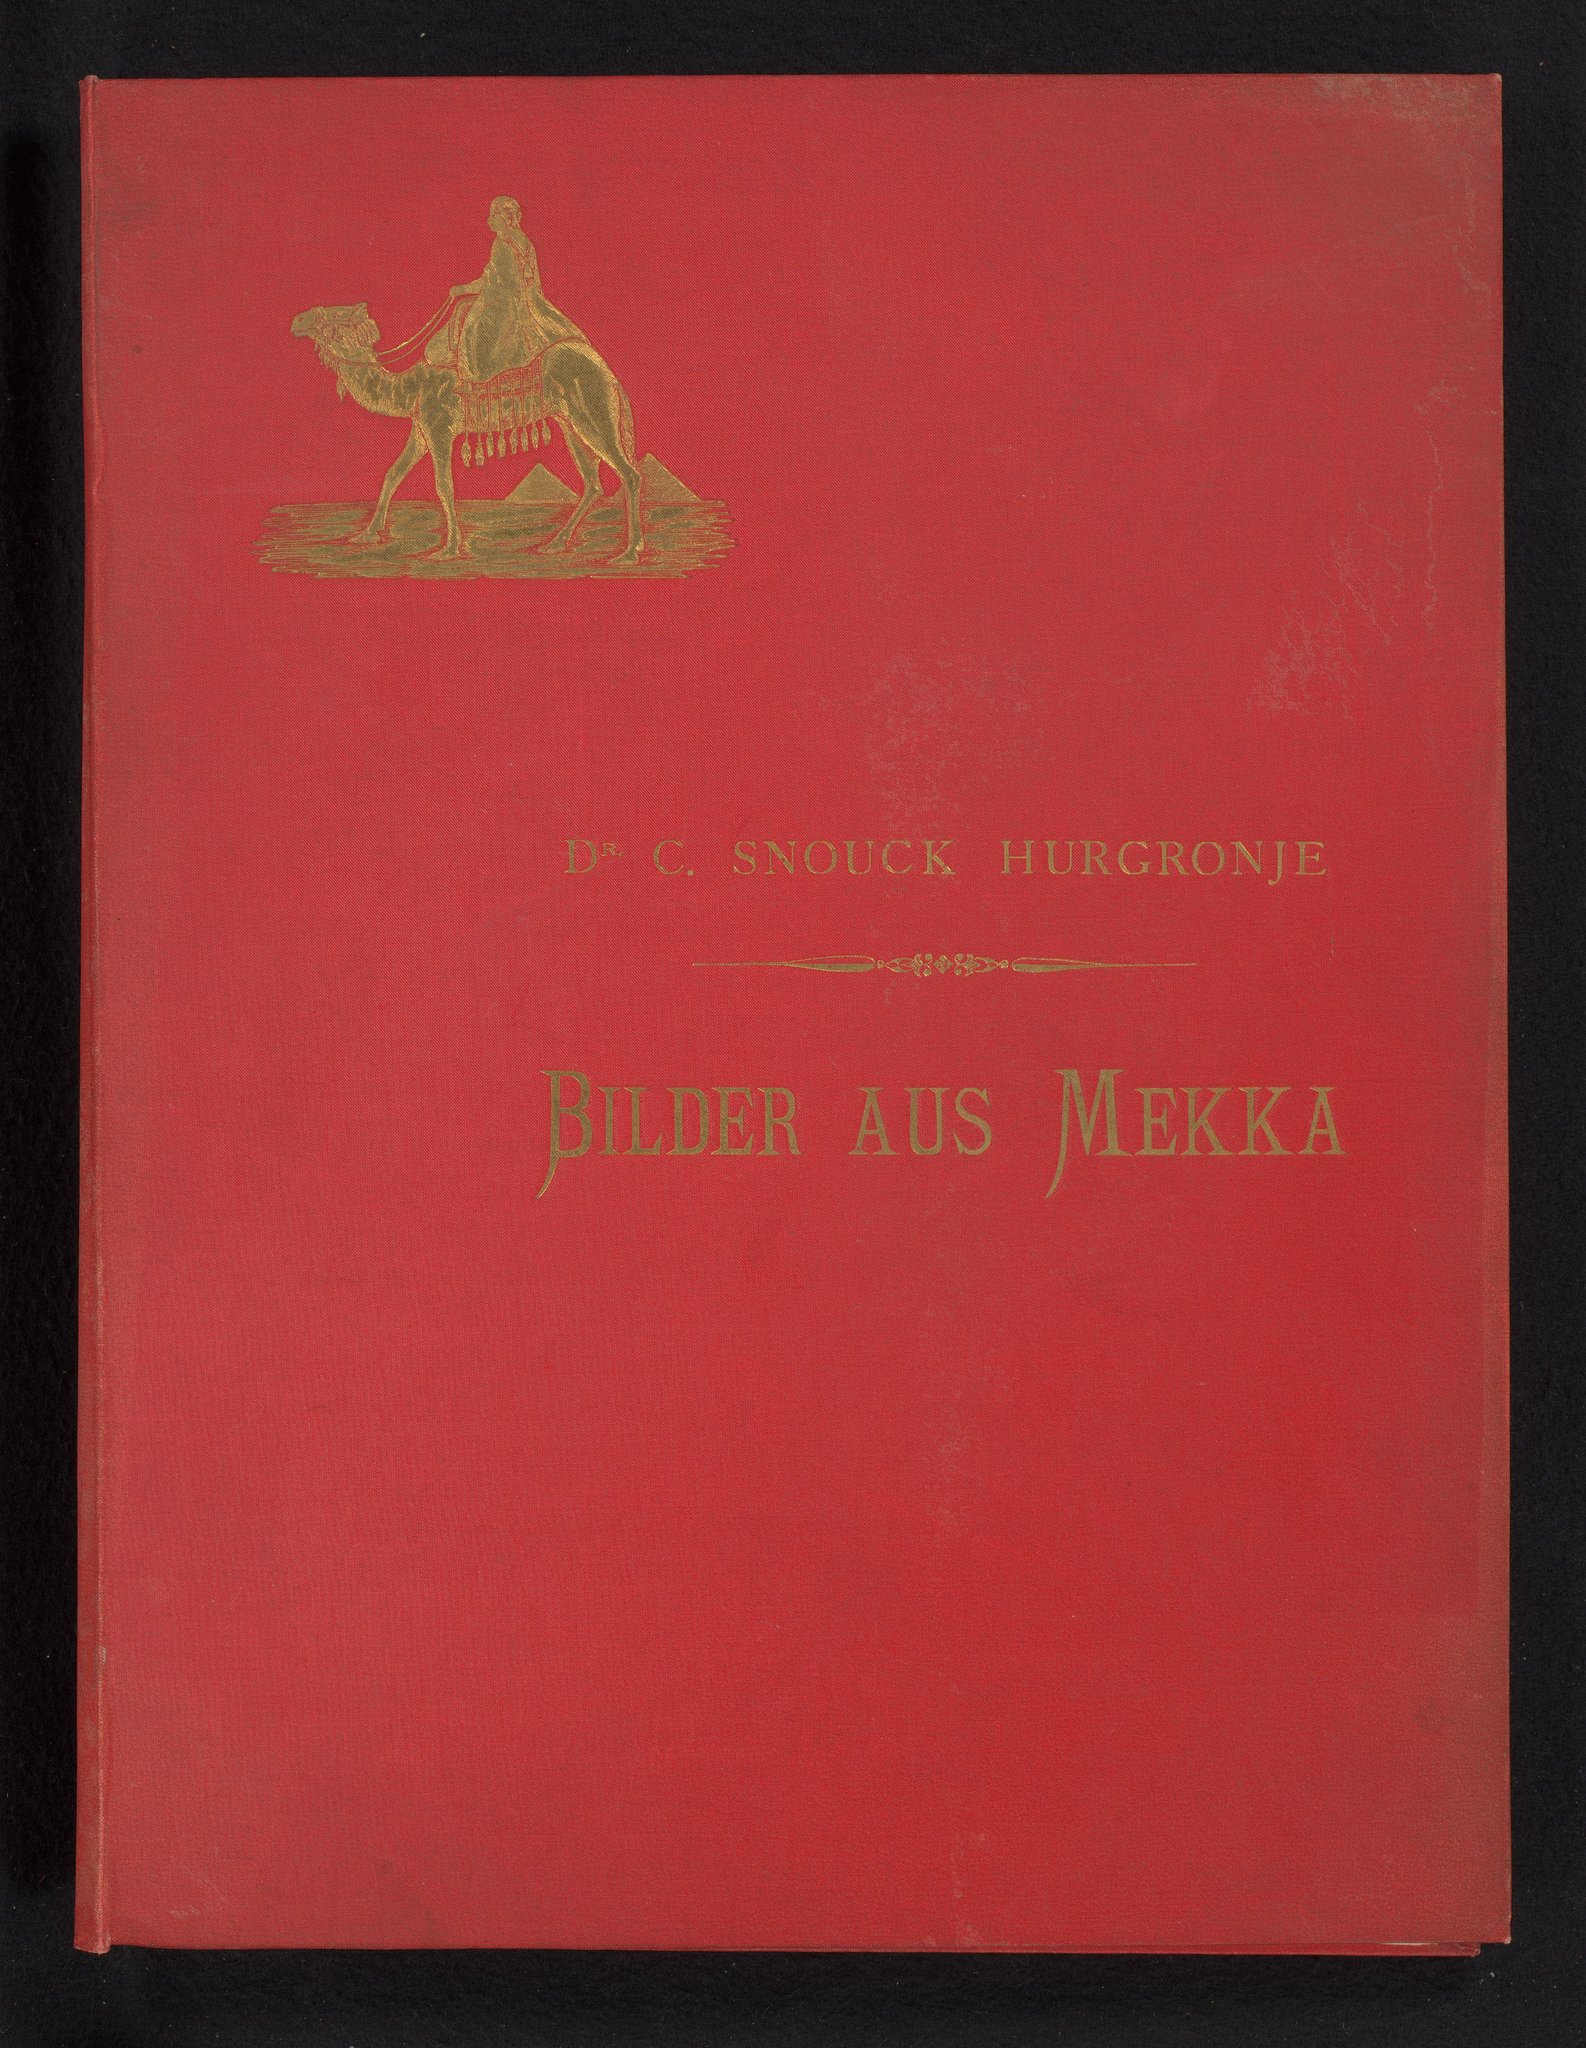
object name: photograph album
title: Bilder aus Mekka, mit kurzem erläuterndem Texte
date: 1889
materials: cardboard, paper, textile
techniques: photograph, letterpress printing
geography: mecca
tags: city-view in general; 'veduta'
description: Omslag voor 20 fotomechanische afdrukken van gezichten in Mekka.